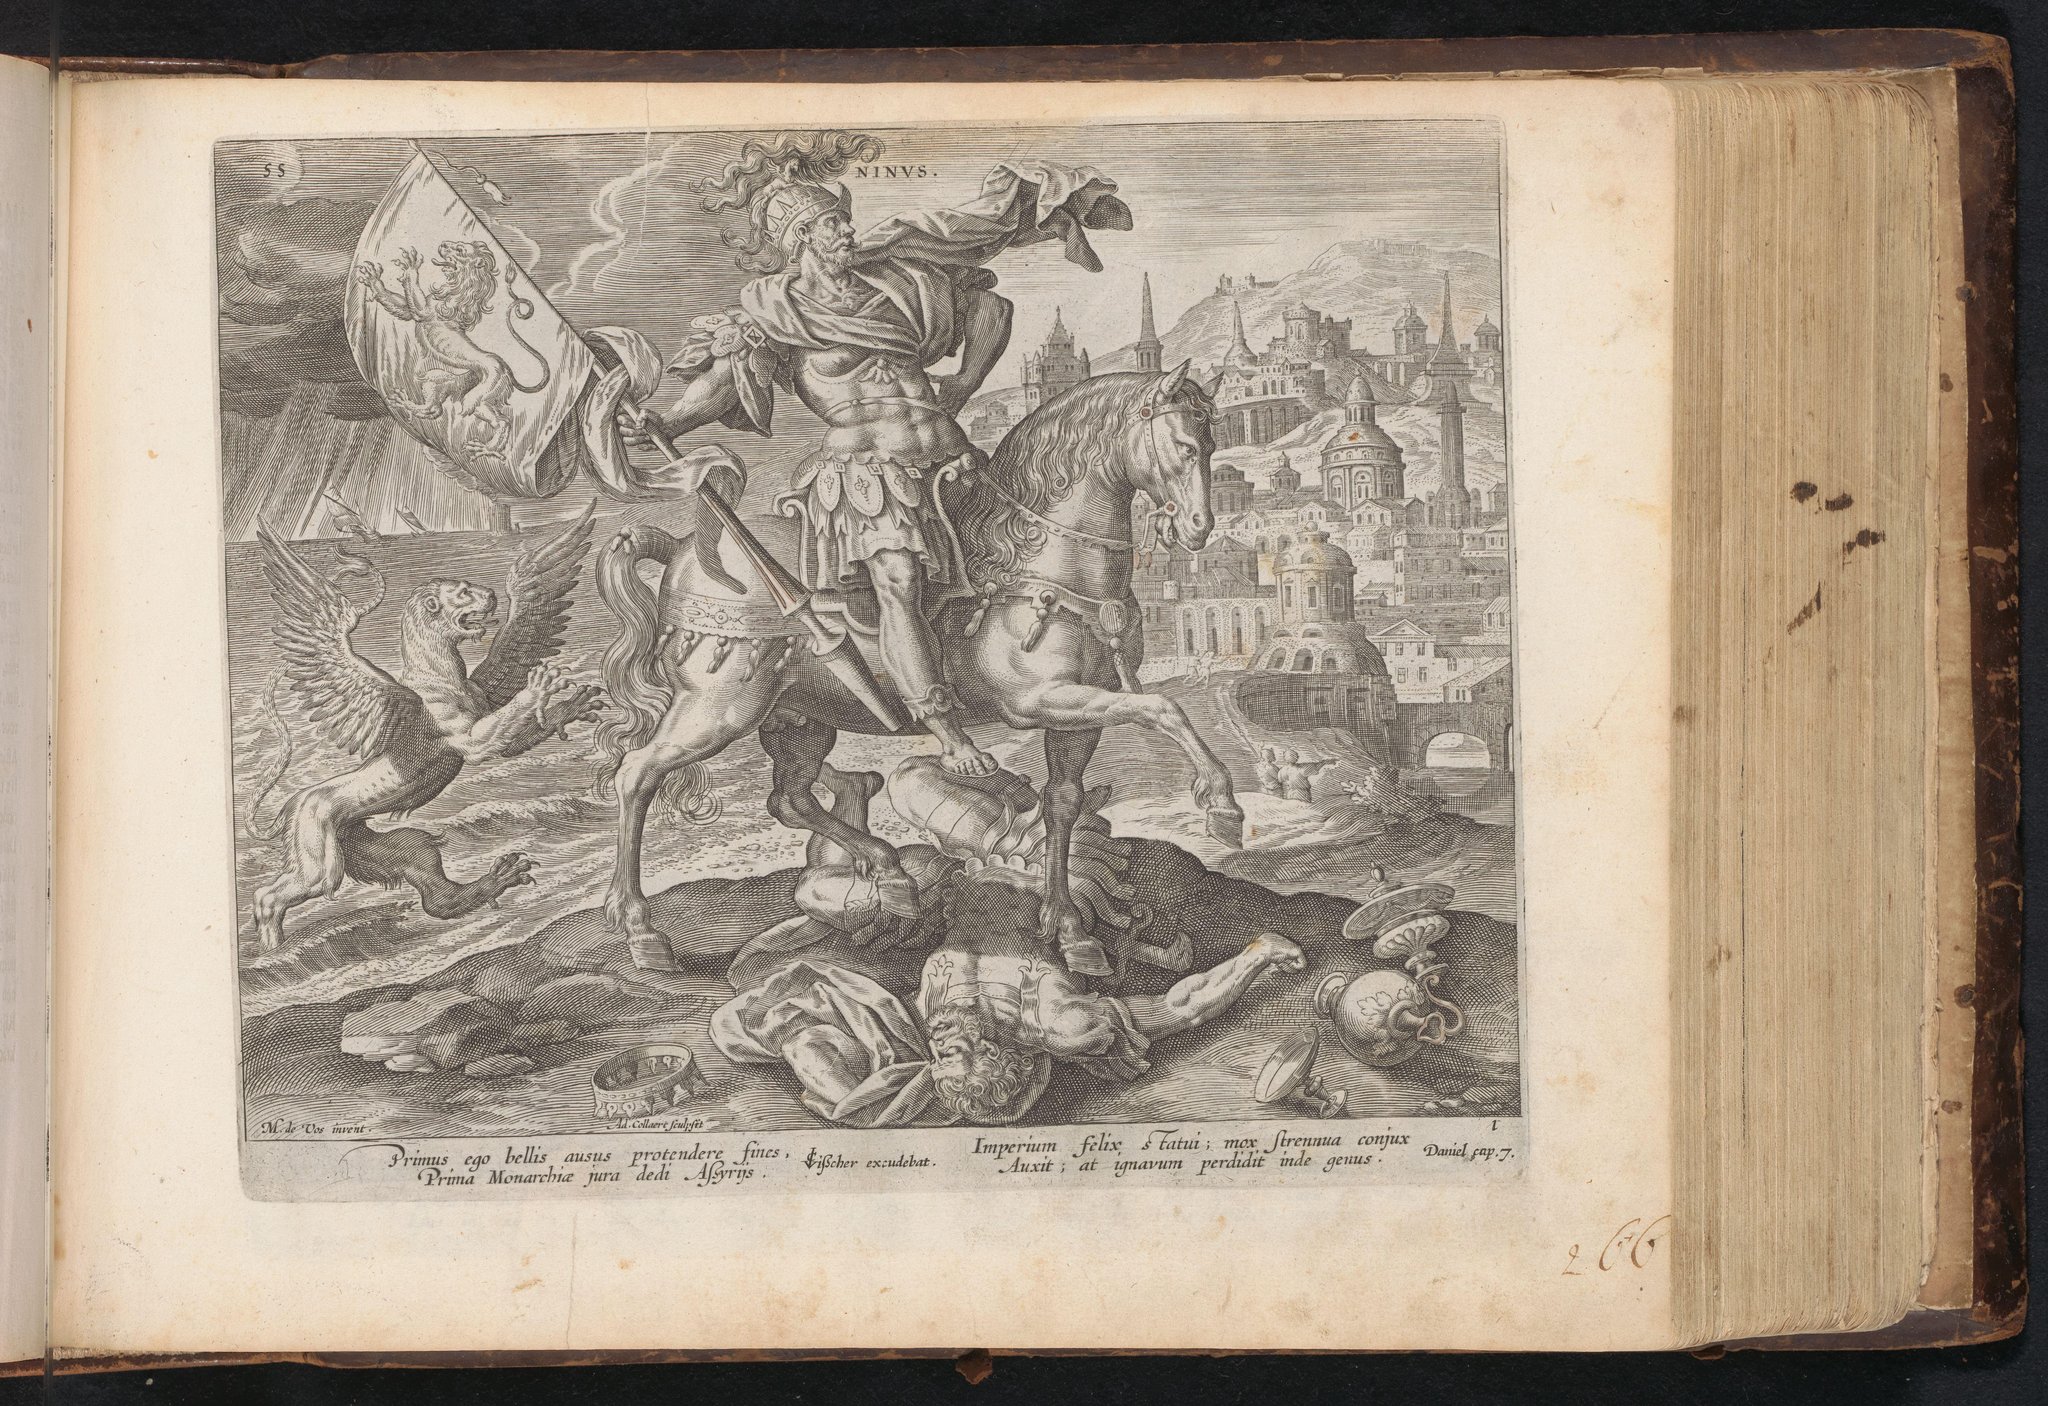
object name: album leaf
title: Opkomst van vier wereldrijken en vier heersers uit het visioen van Daniël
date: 1570-1618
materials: paper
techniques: engraving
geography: alkmaar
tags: male persons from classical history (ninus of niniveh), the world empires symbolized by four beasts (daniel ch. 7), the lion with eagle's wings (griffin), standing on its hind legs ~ daniel's visions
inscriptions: number: ‘266’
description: Ninus, stichter van Nineve en berucht veldheer, rijdt op een paard, in zijn hand een vlag met de afbeelding van een leeuw (Babylonië). Het paard vertrapt koning Oxyartes van Bactrië. Op de achtergrond een stadsgezicht. Naast Ninus komt uit de zee een leeuw met adelaarsvleugels tevoorschijn, een verwijzing naar een visioen van Daniël over de opkomst van vier koninkrijken in de wereld. Onder de voorstelling een verwijzing in het Latijn naar de Bijbeltekst in Dan. 7. Deze prent maakt deel uit van een album.